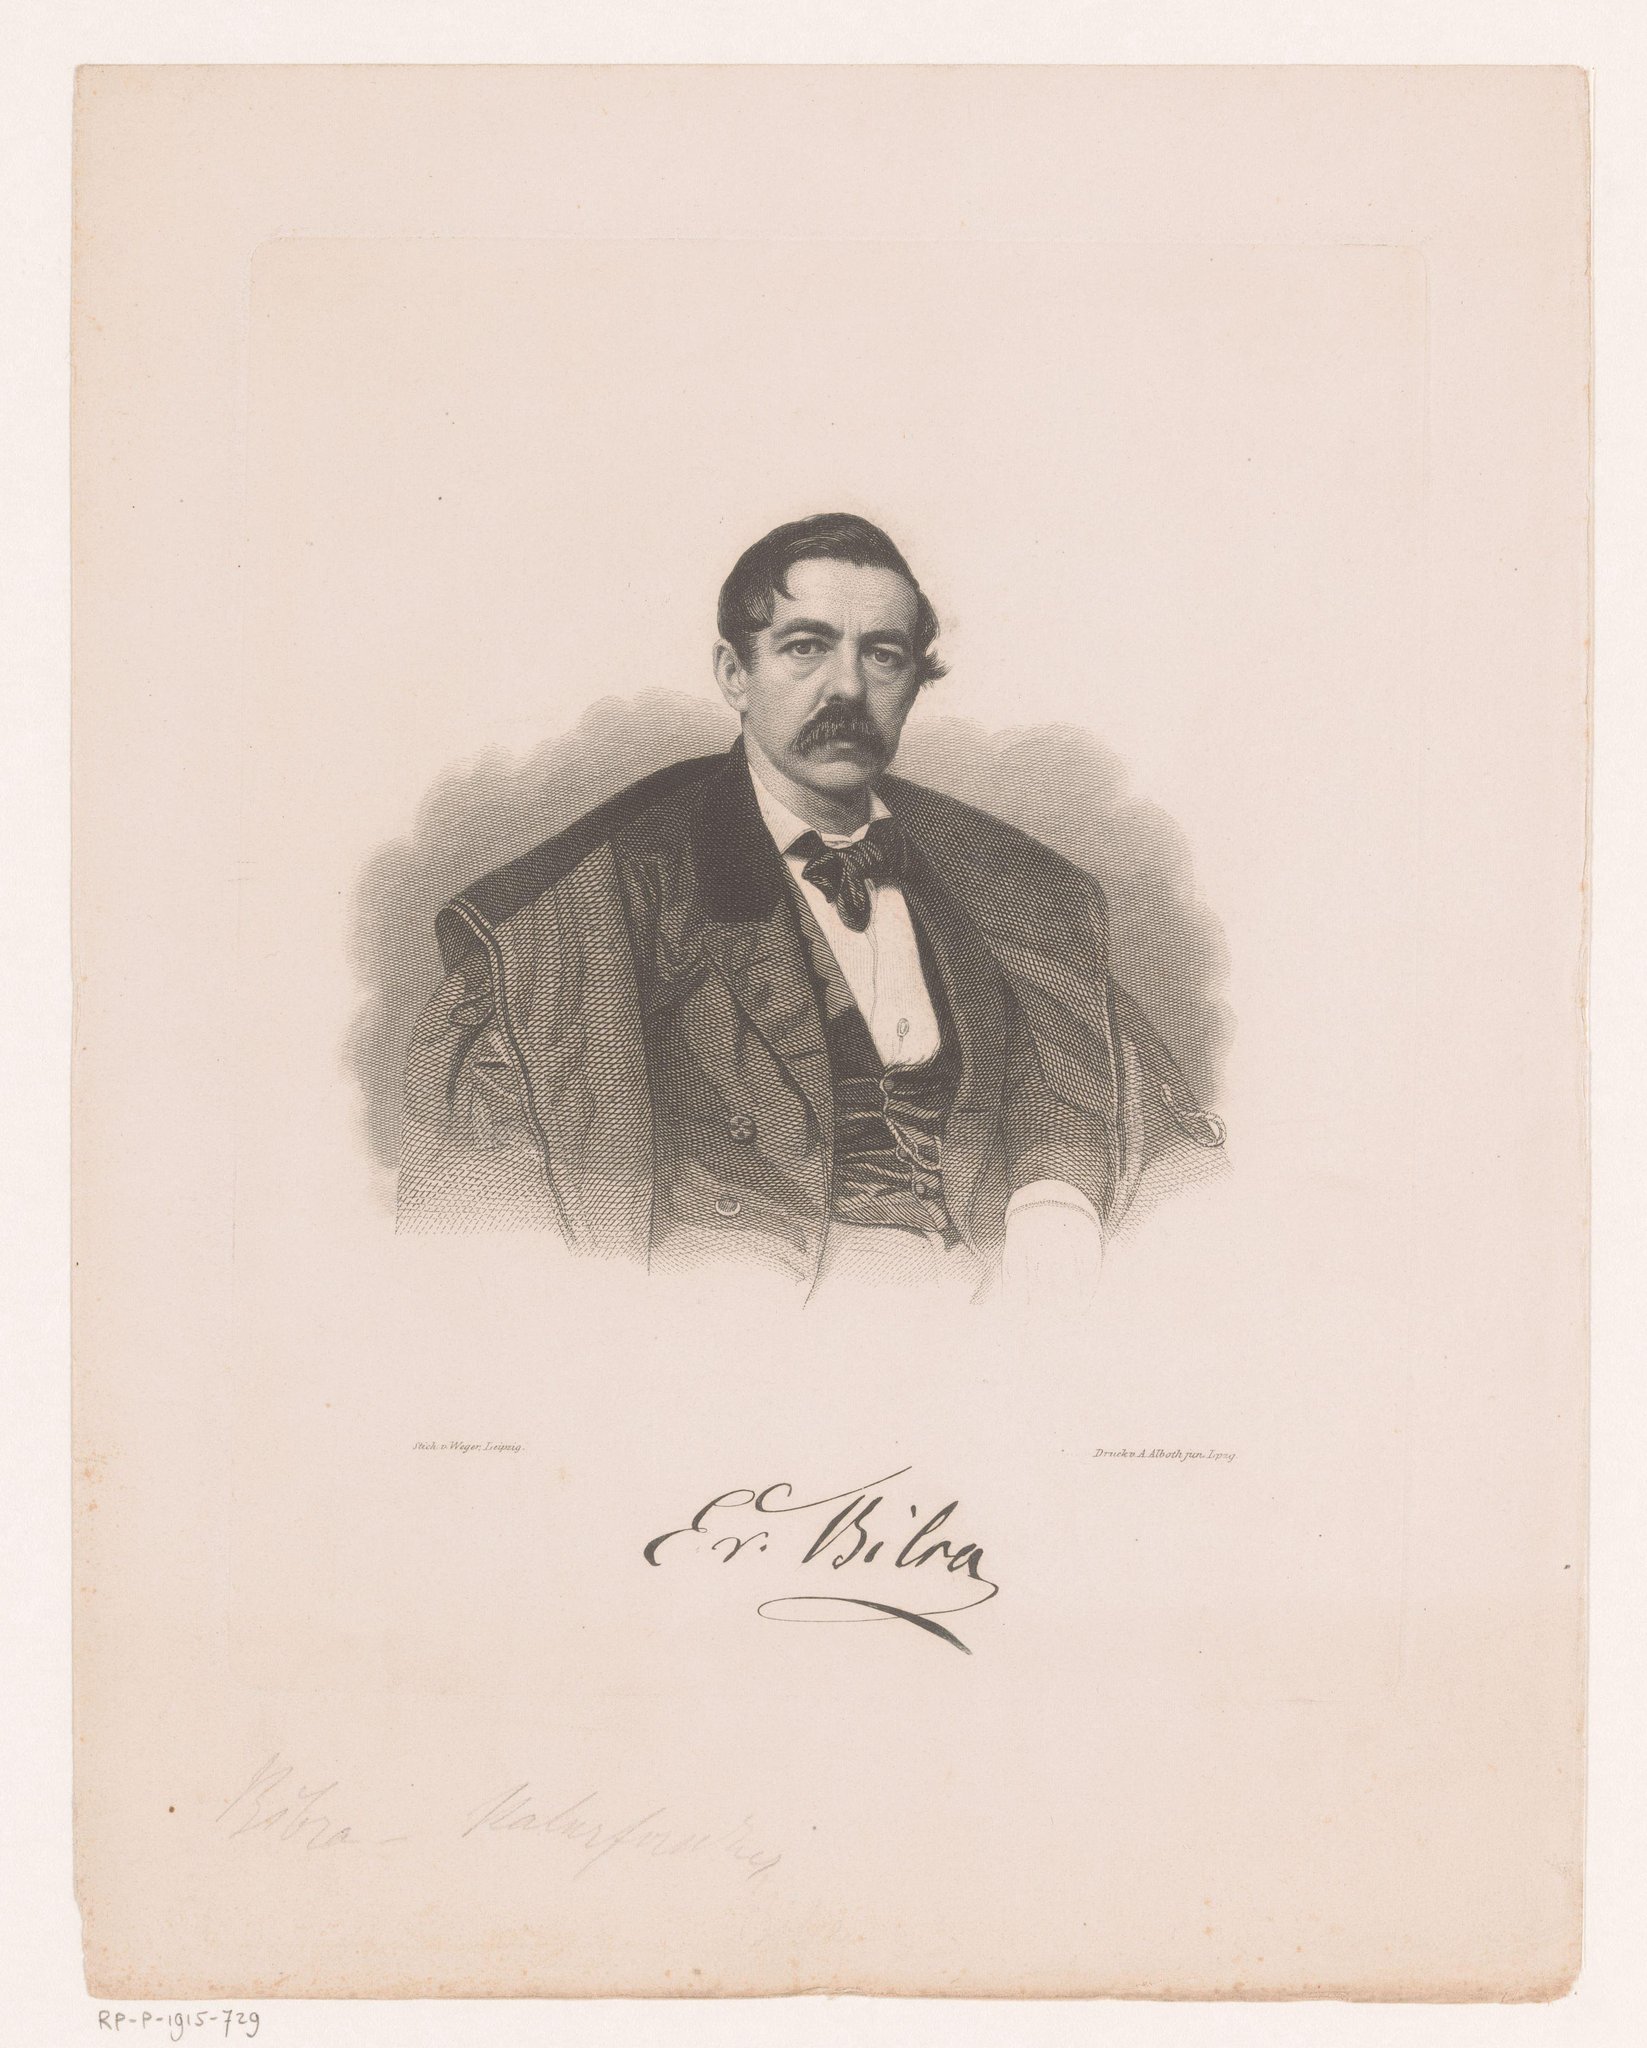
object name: print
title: Portret van Józef Bem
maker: august weger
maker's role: print maker, printer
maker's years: 1823-1892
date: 1849-1892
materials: paper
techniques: engraving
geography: leipzig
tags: engineer, historical persons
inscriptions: collector's mark: Lugt 2228